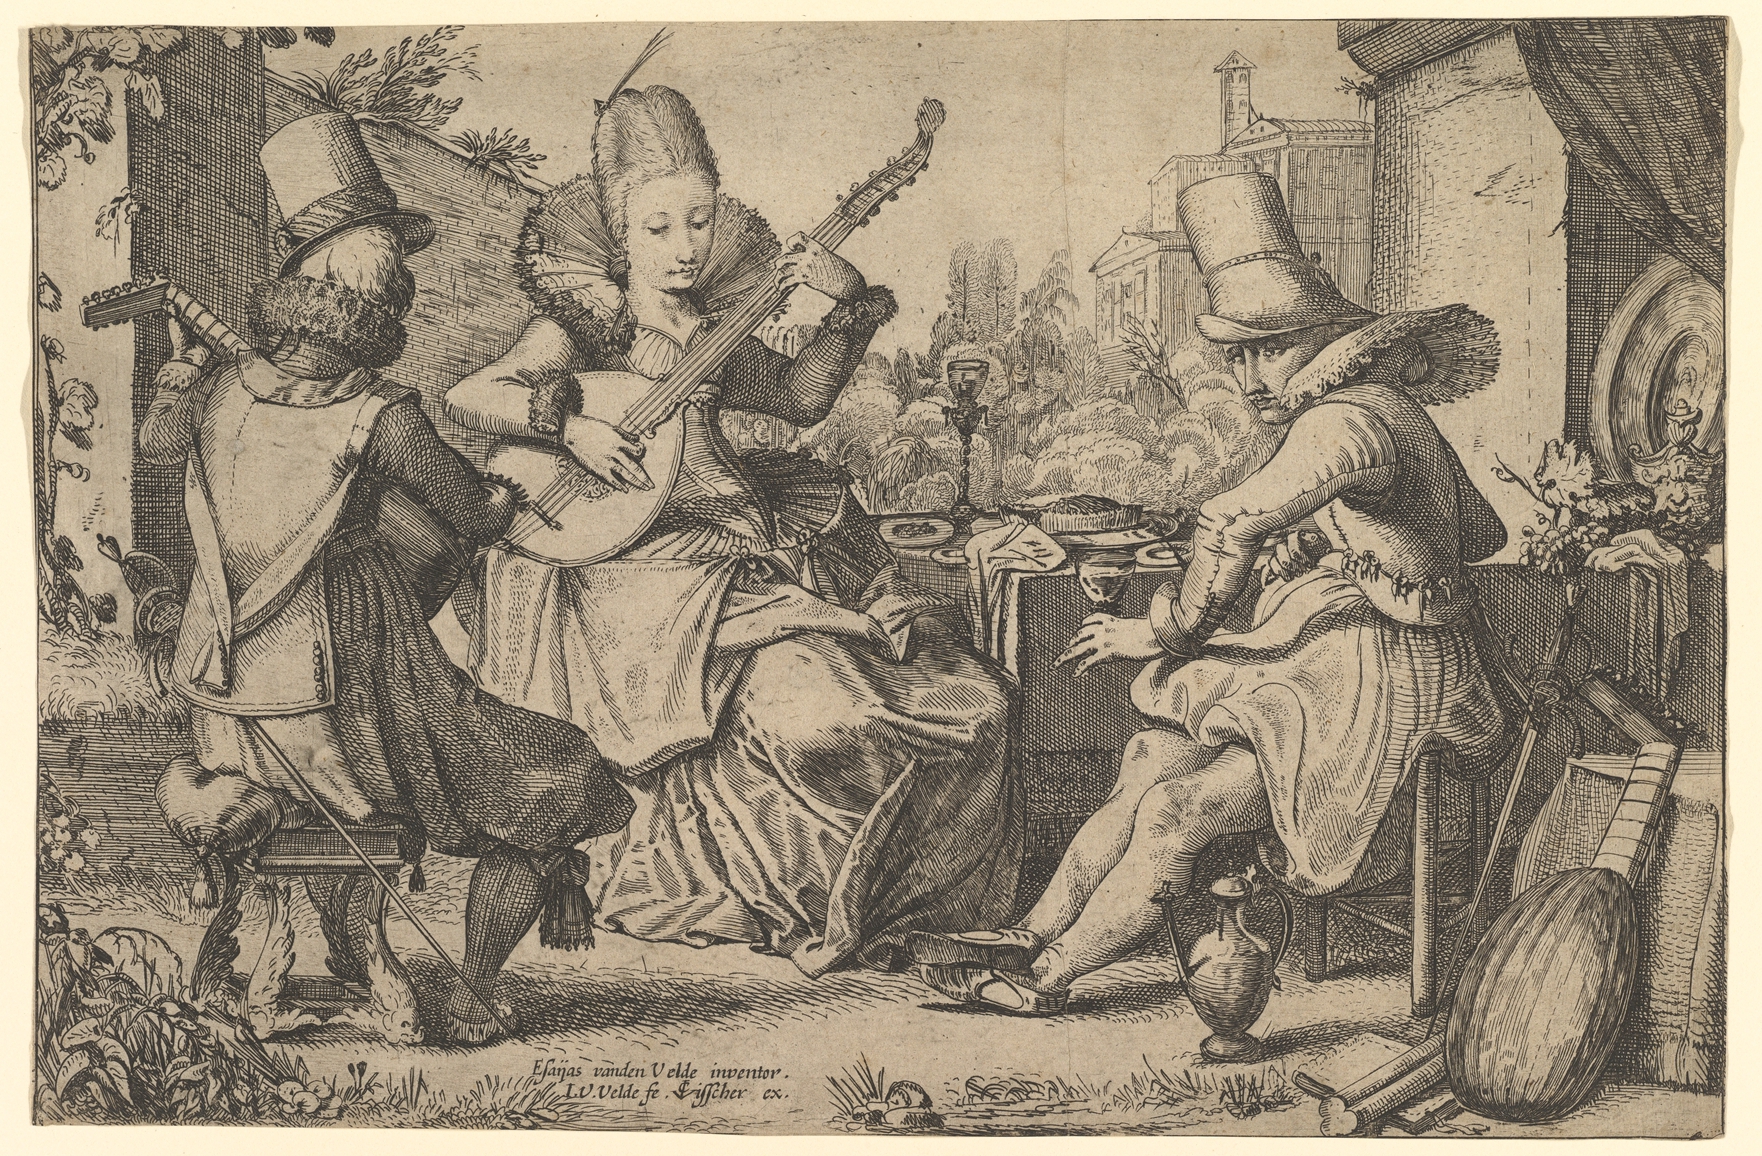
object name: print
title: Two Elegantly Dressed Men and a Woman in a Garden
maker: jan van de velde ii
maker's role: artist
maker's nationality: dutch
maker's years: 1593-1641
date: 1613-1641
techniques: engraving, etching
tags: musical instruments,men,women,lutes,musicians